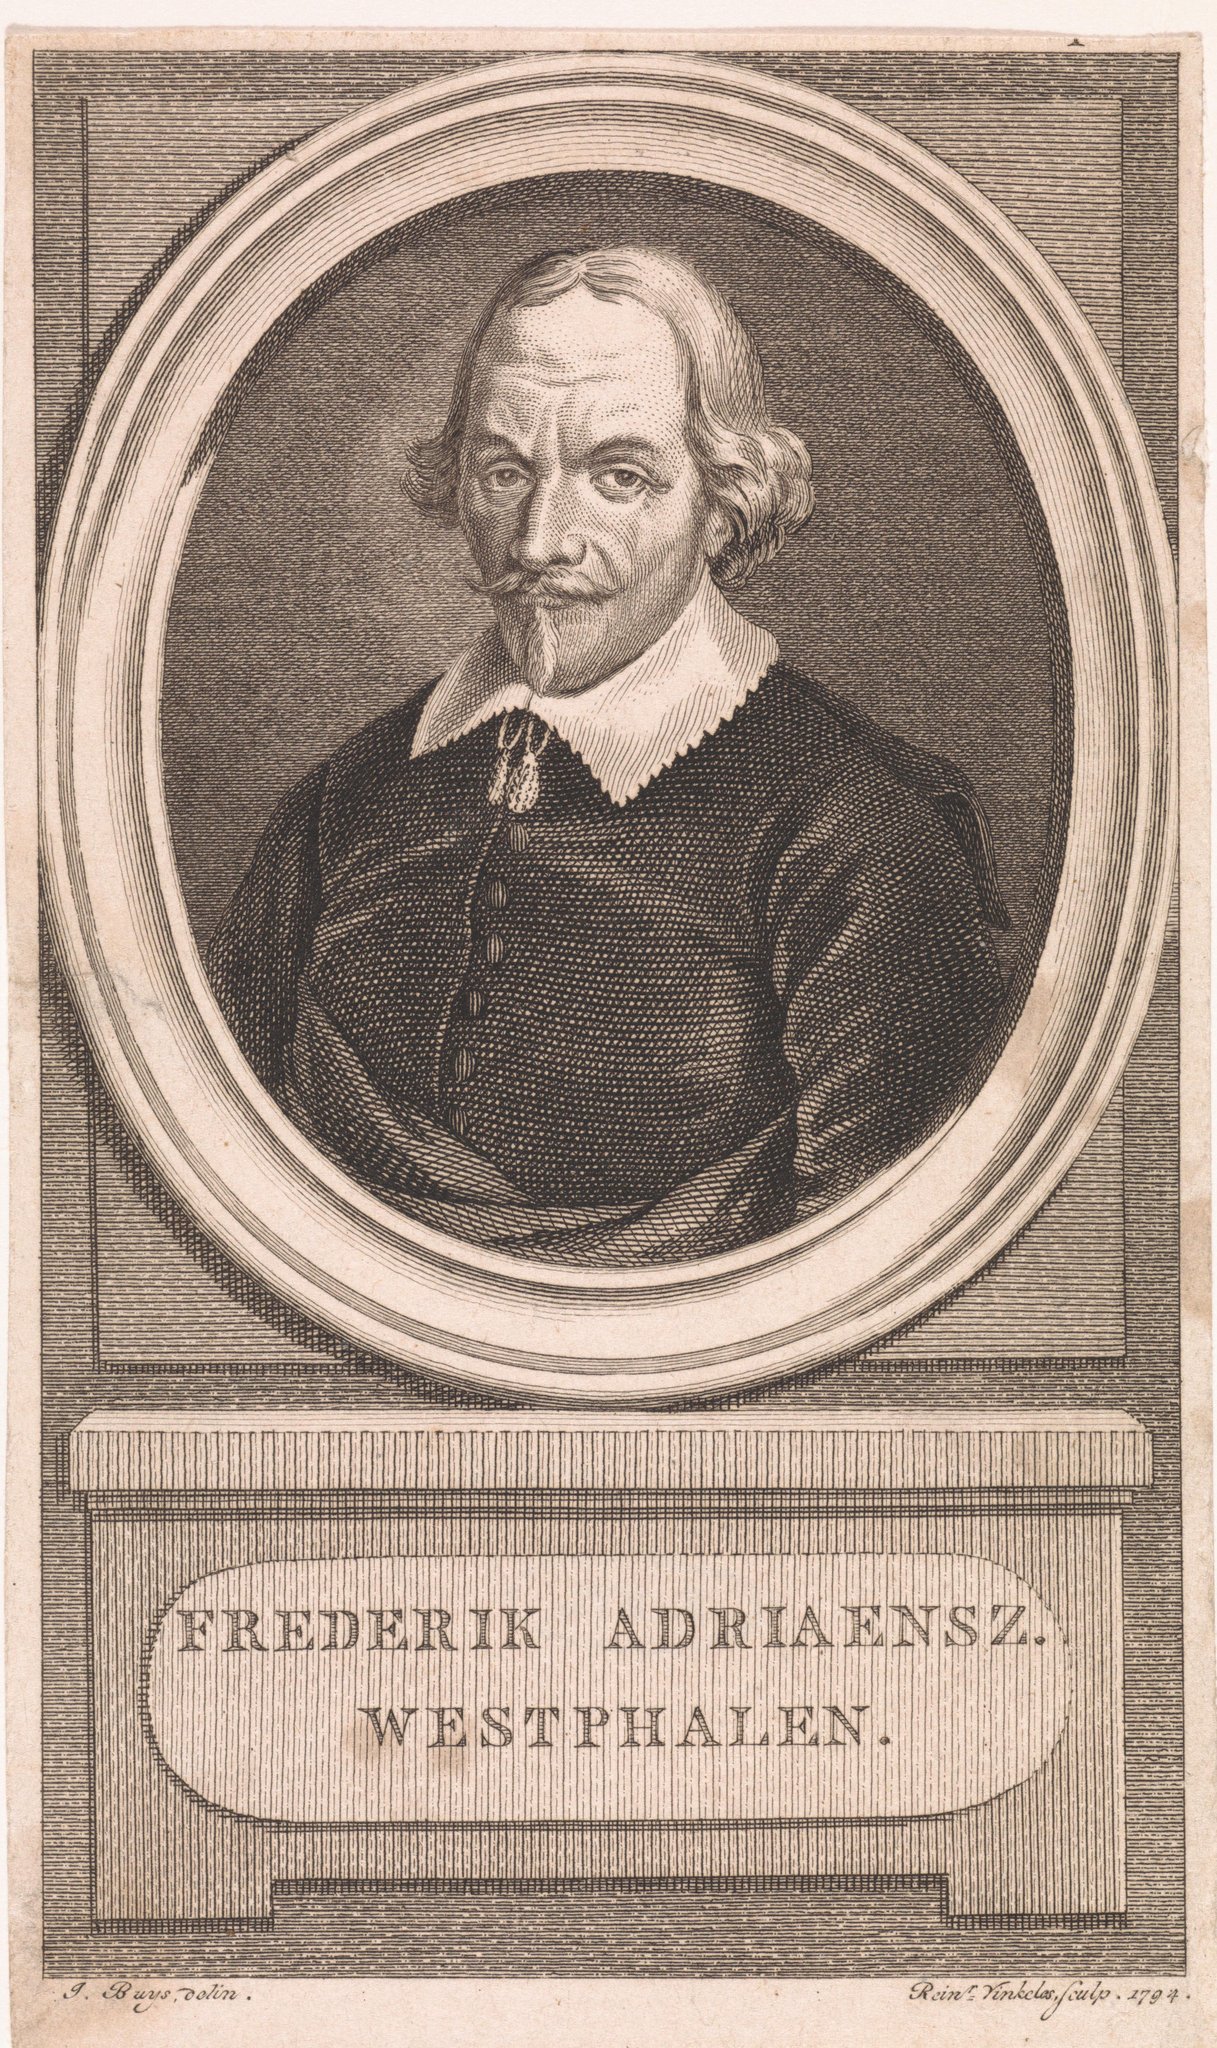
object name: print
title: Portret van Frederik Adriaensz. Westphalen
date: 1794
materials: paper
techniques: engraving, etching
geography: amsterdam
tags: enkhuizen, traveler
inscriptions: collector's mark: Lugt 2228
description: Prent gebruikt als boekillustratie in: Kok, Jacobus. Vaderlandsch woordenboek : met kaarten, plaaten en pourtraitten. Amsterdam: Johannes Allart, 1785-1796. Deel XXXI.